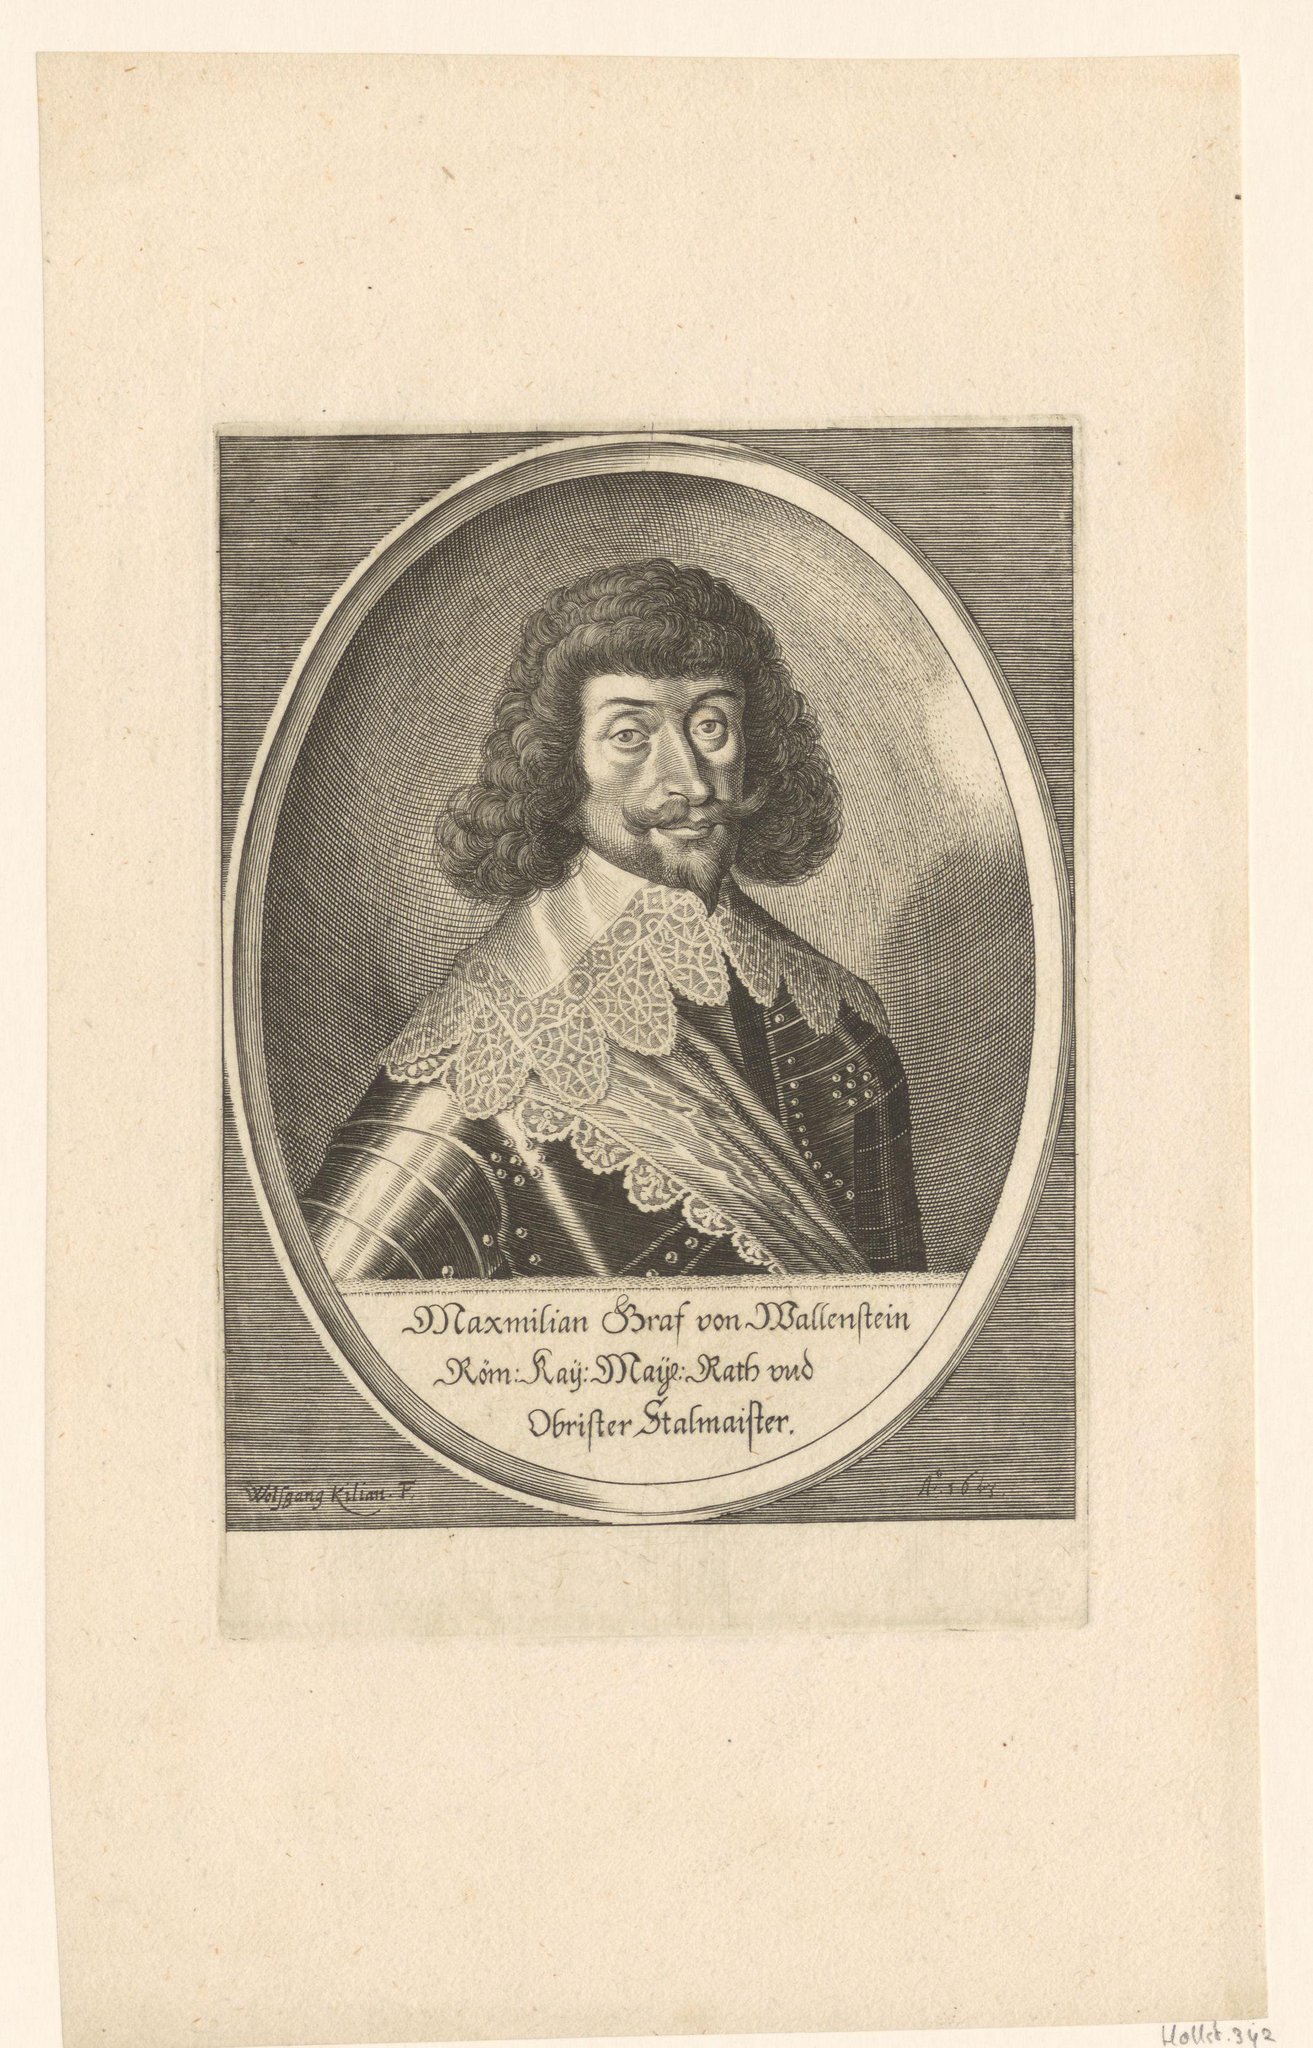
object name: print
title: Portret van Maximilian graaf van Waldstein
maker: wolfgang kilian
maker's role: print maker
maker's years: 1581-1662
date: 1643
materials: paper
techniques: engraving, etching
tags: historical persons, ambassador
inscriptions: collector's mark: Lugt 2228